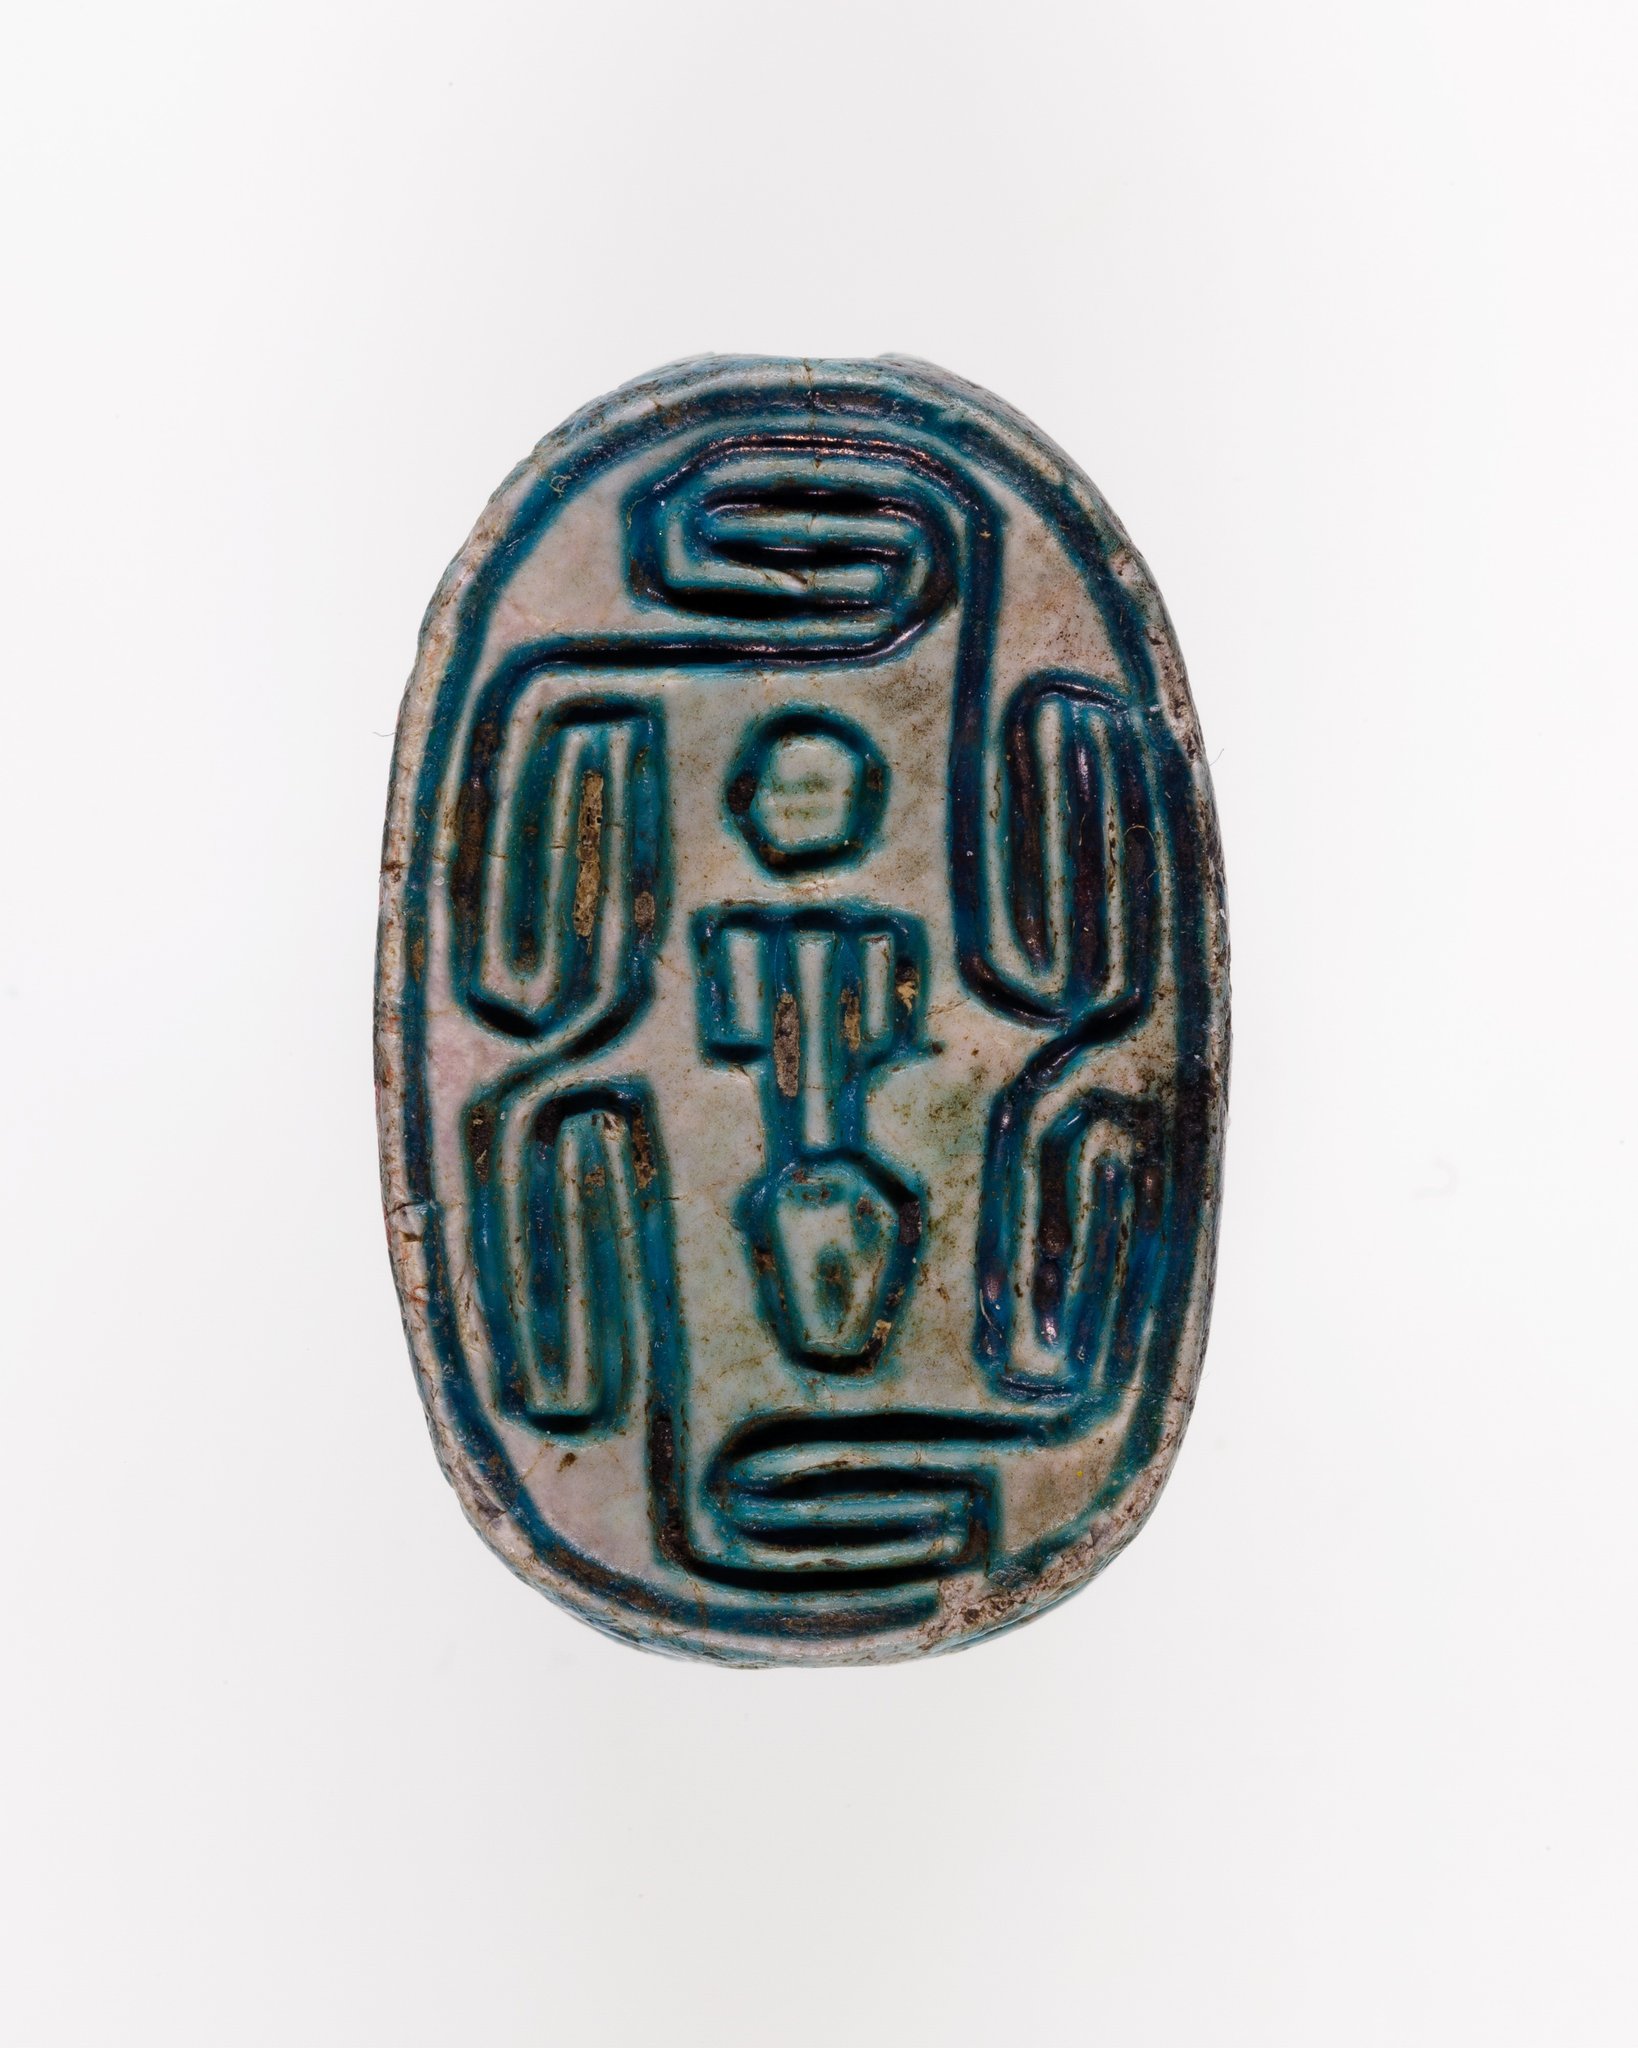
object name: scarab, nefer, scroll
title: Scarab Inscribed with Hieroglyphs in a Scroll Border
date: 1850-1640 BCE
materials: stone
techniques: glazing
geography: egypt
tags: scarabs